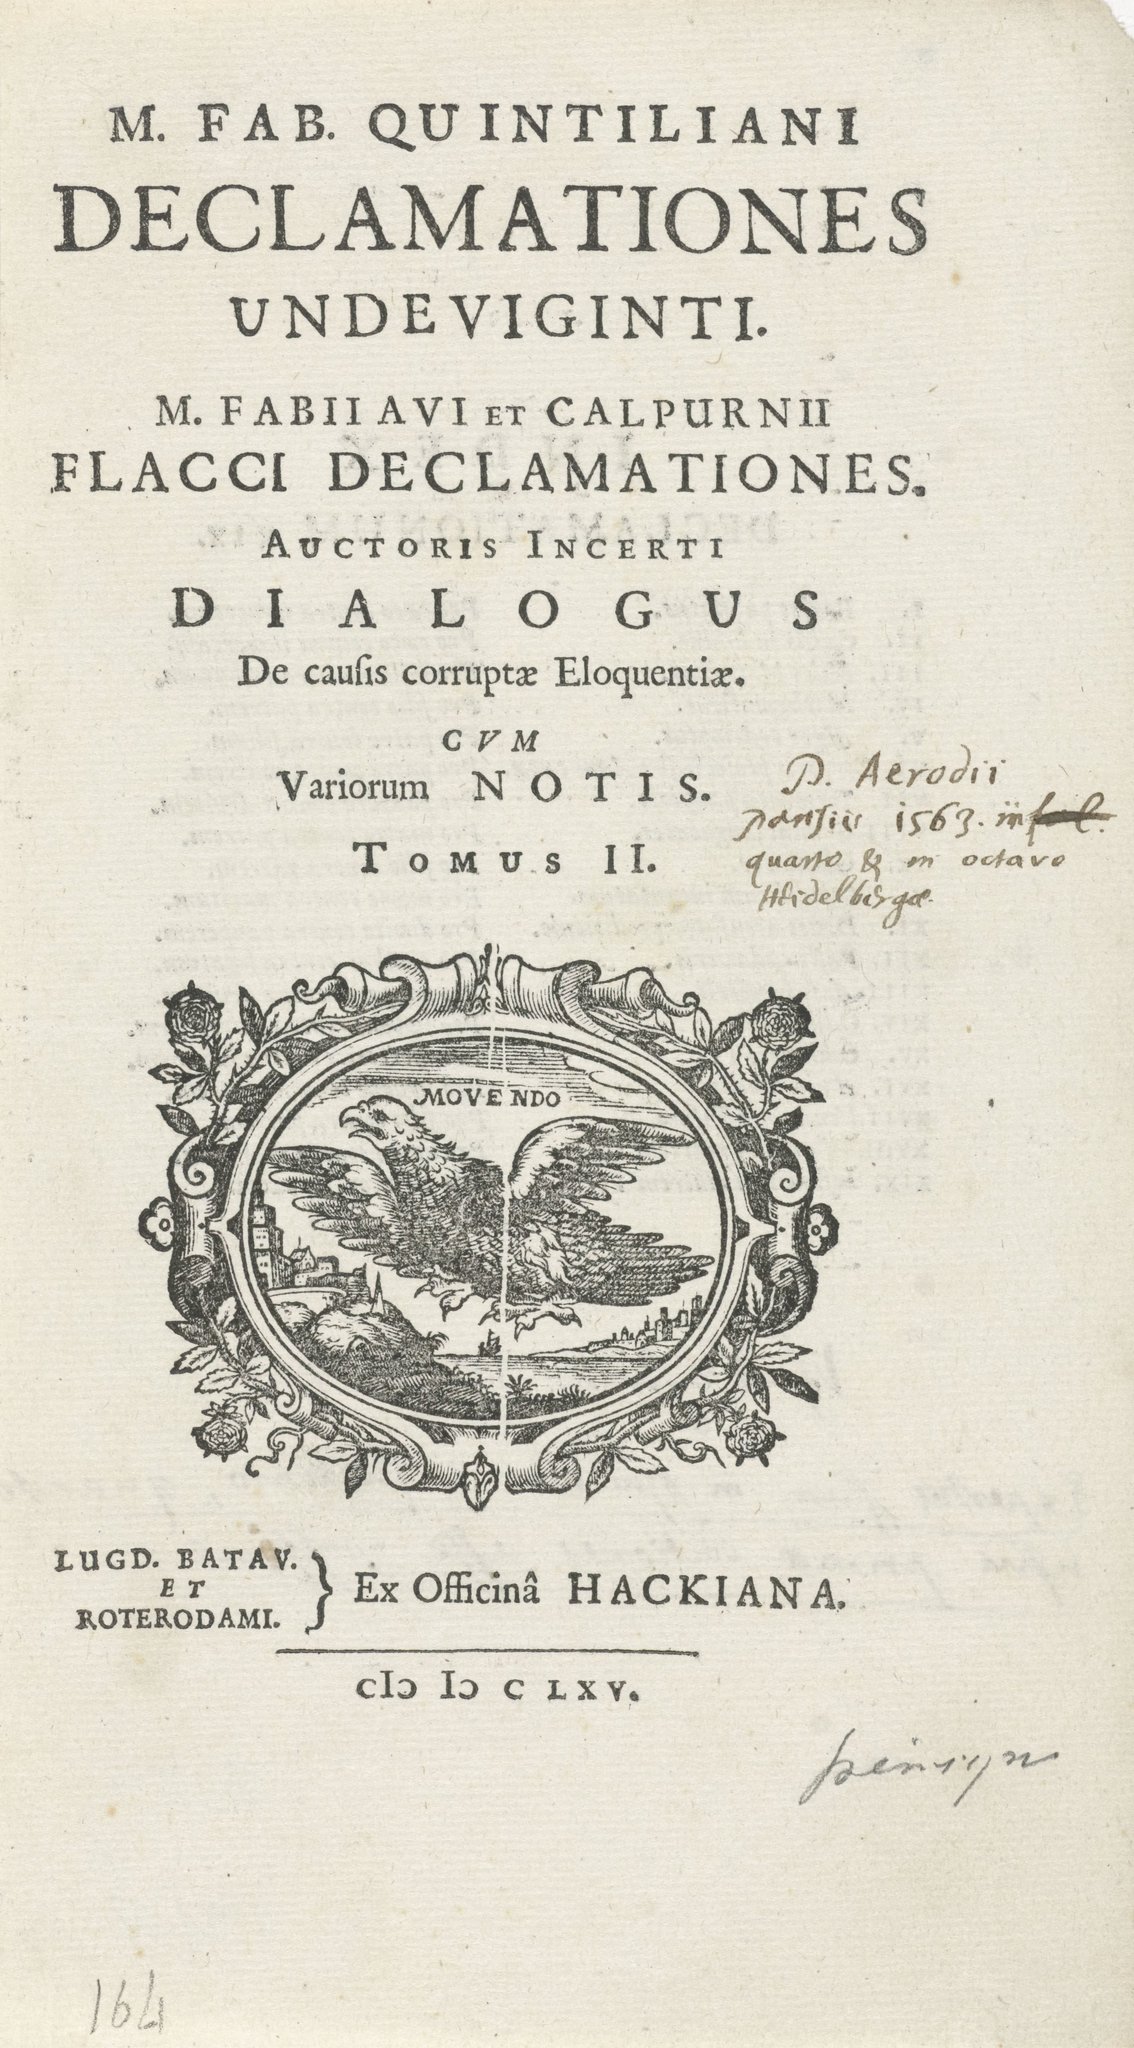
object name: print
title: Cartouche met adelaar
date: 1665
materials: paper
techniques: letterpress printing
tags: predatory birds: eagle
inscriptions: inscription, inscription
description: Titelpagina voor: Fabius Quintilianus, M., Institutionum oratoriarum libri duodecim [Declamationes undeviginti], deel II. Leiden en Rotterdam: F. Hack, 1665.